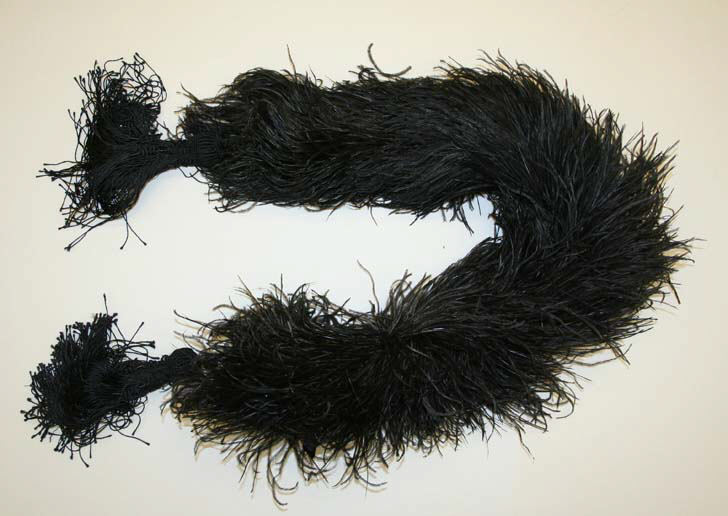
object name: boa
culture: american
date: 1801-1900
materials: feather, silk